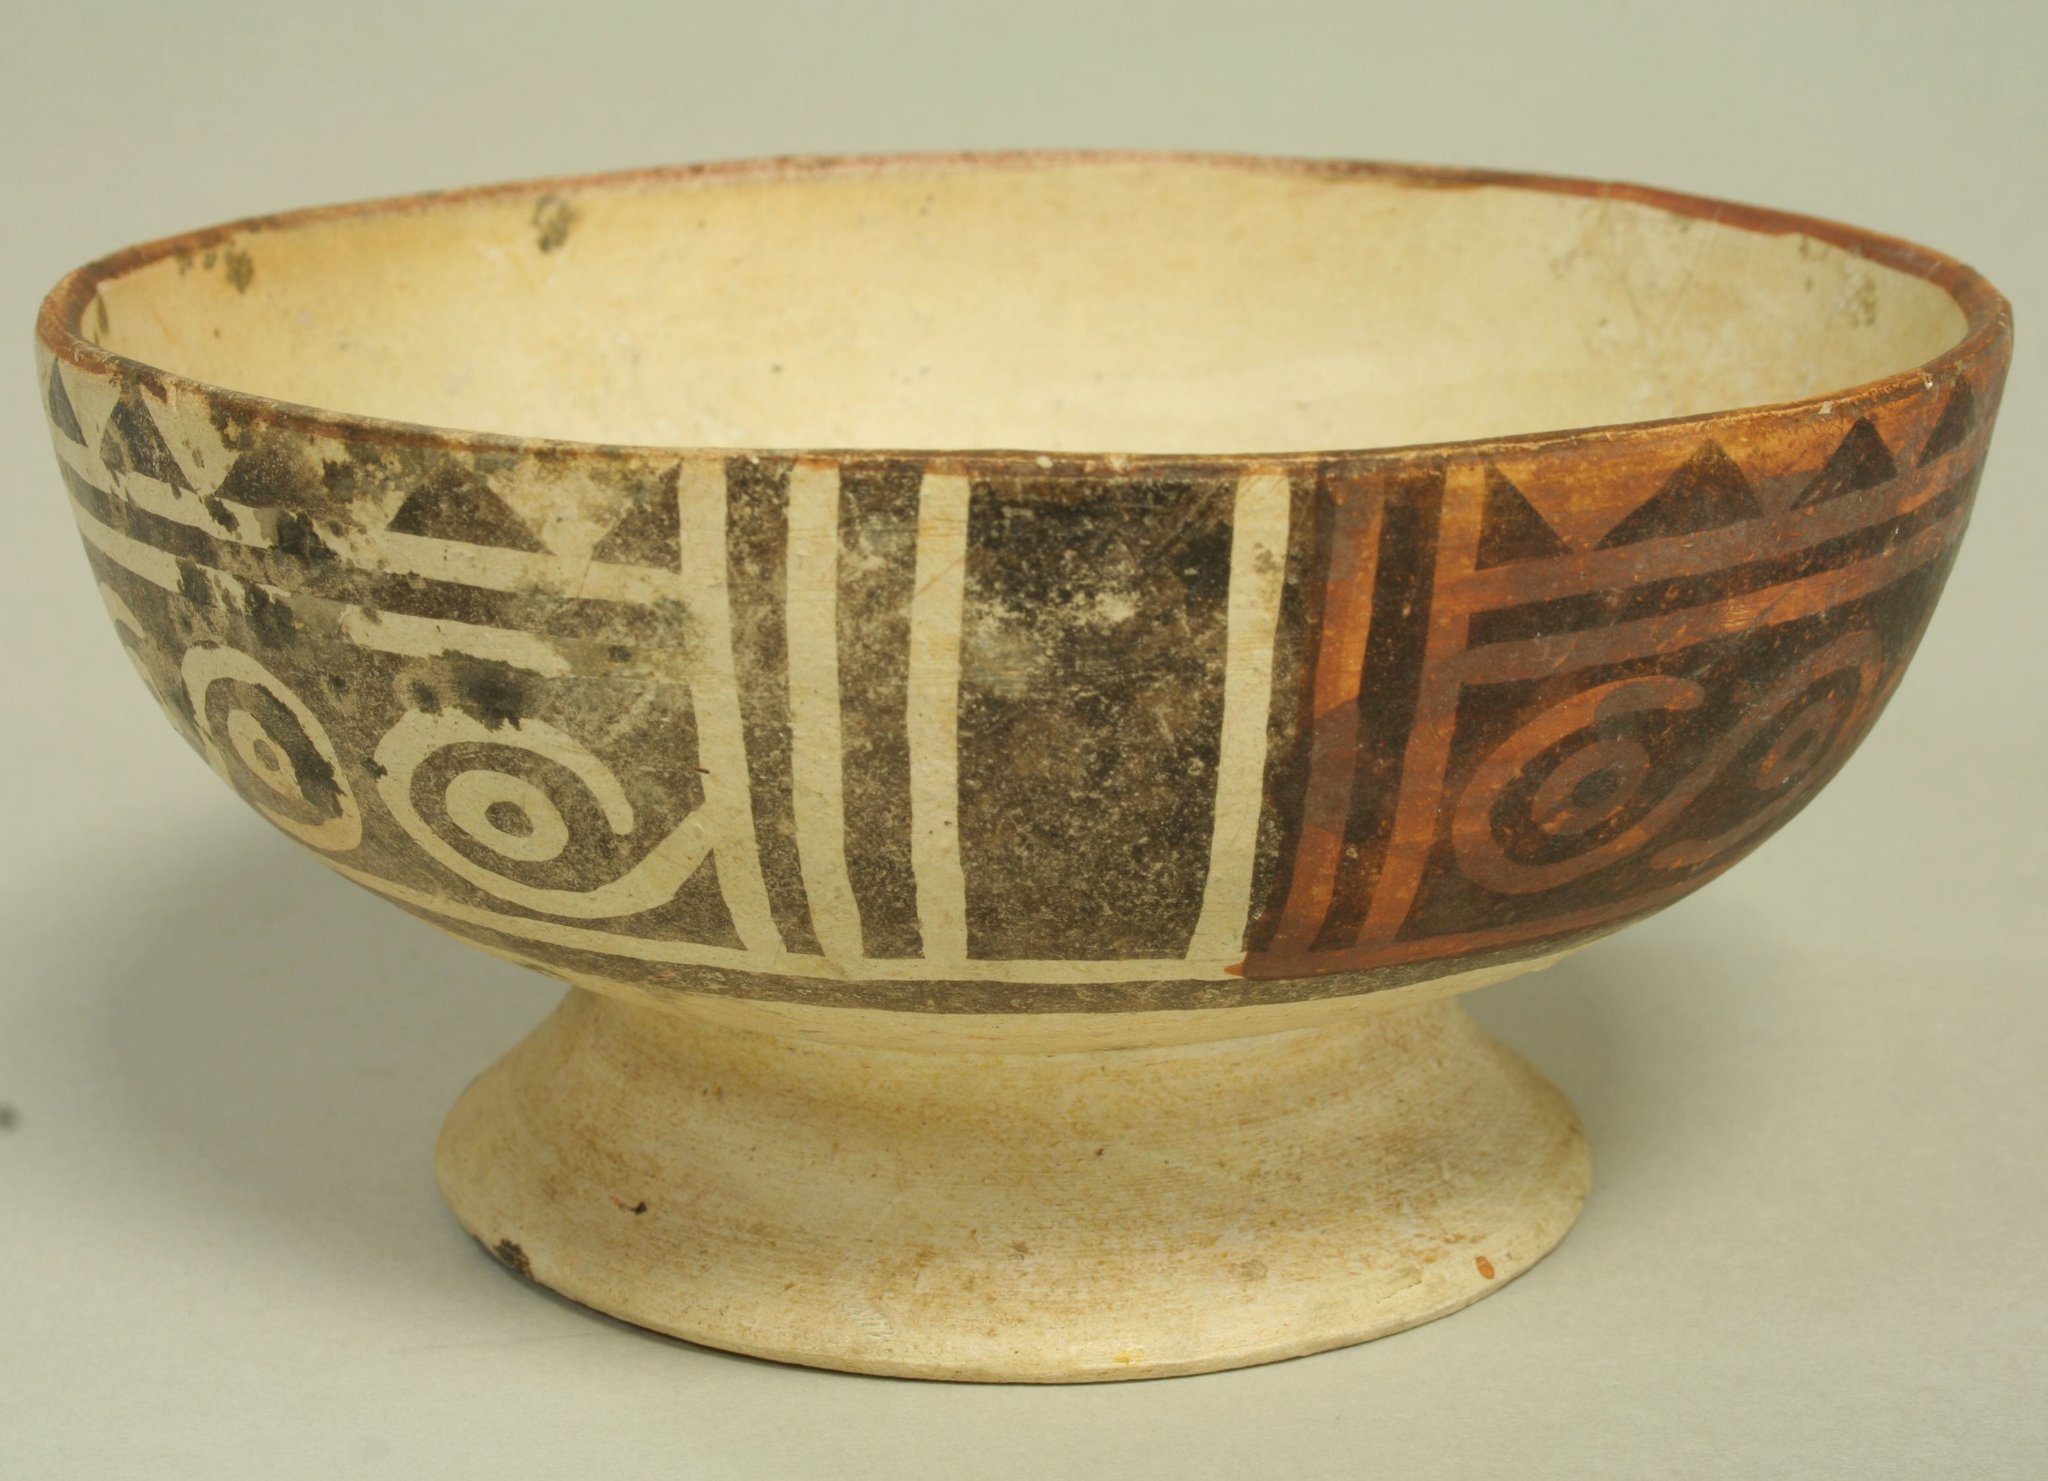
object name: bowl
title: Pedestal Bowl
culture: recuay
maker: recuay artist(s)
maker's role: artist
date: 200-700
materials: ceramic, pigment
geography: peru